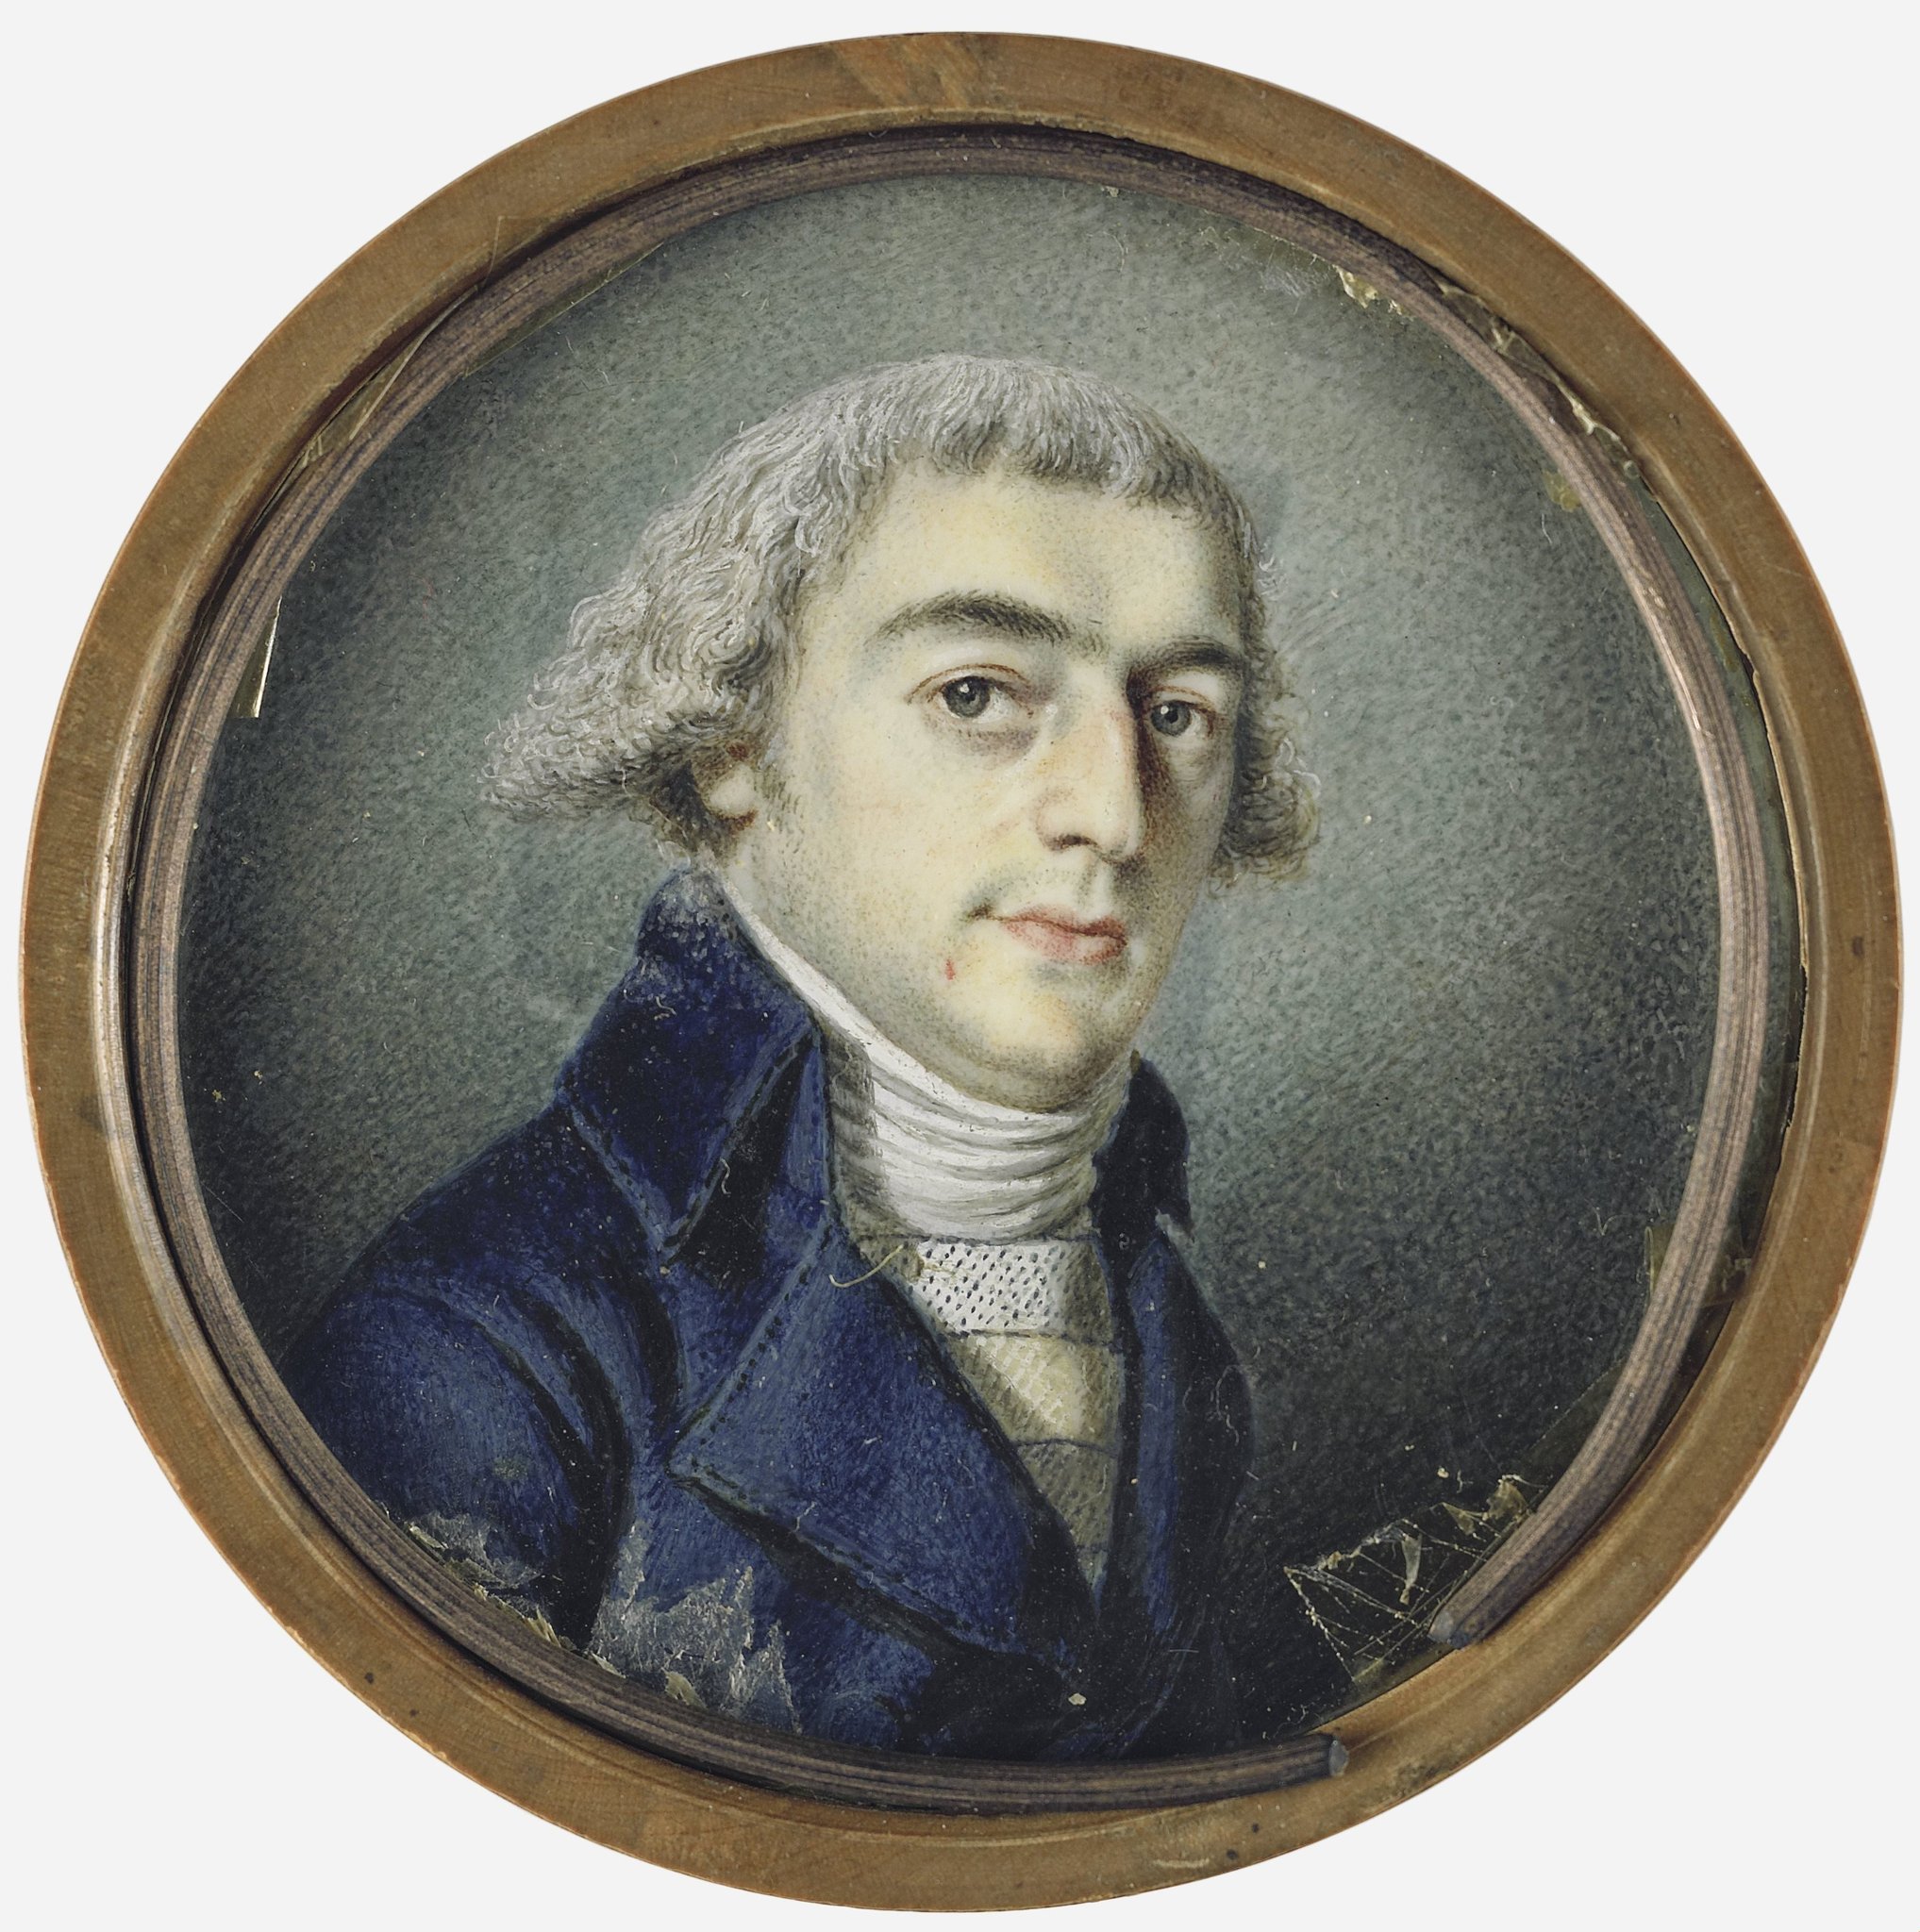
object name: painting, miniature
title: Portret van een man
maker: Anonymous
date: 1790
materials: glass, ivory, wood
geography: northern netherlands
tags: anonymous historical person portrayed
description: Portrait of a man. Northern Netherlands school. Ivory, c. 1790.